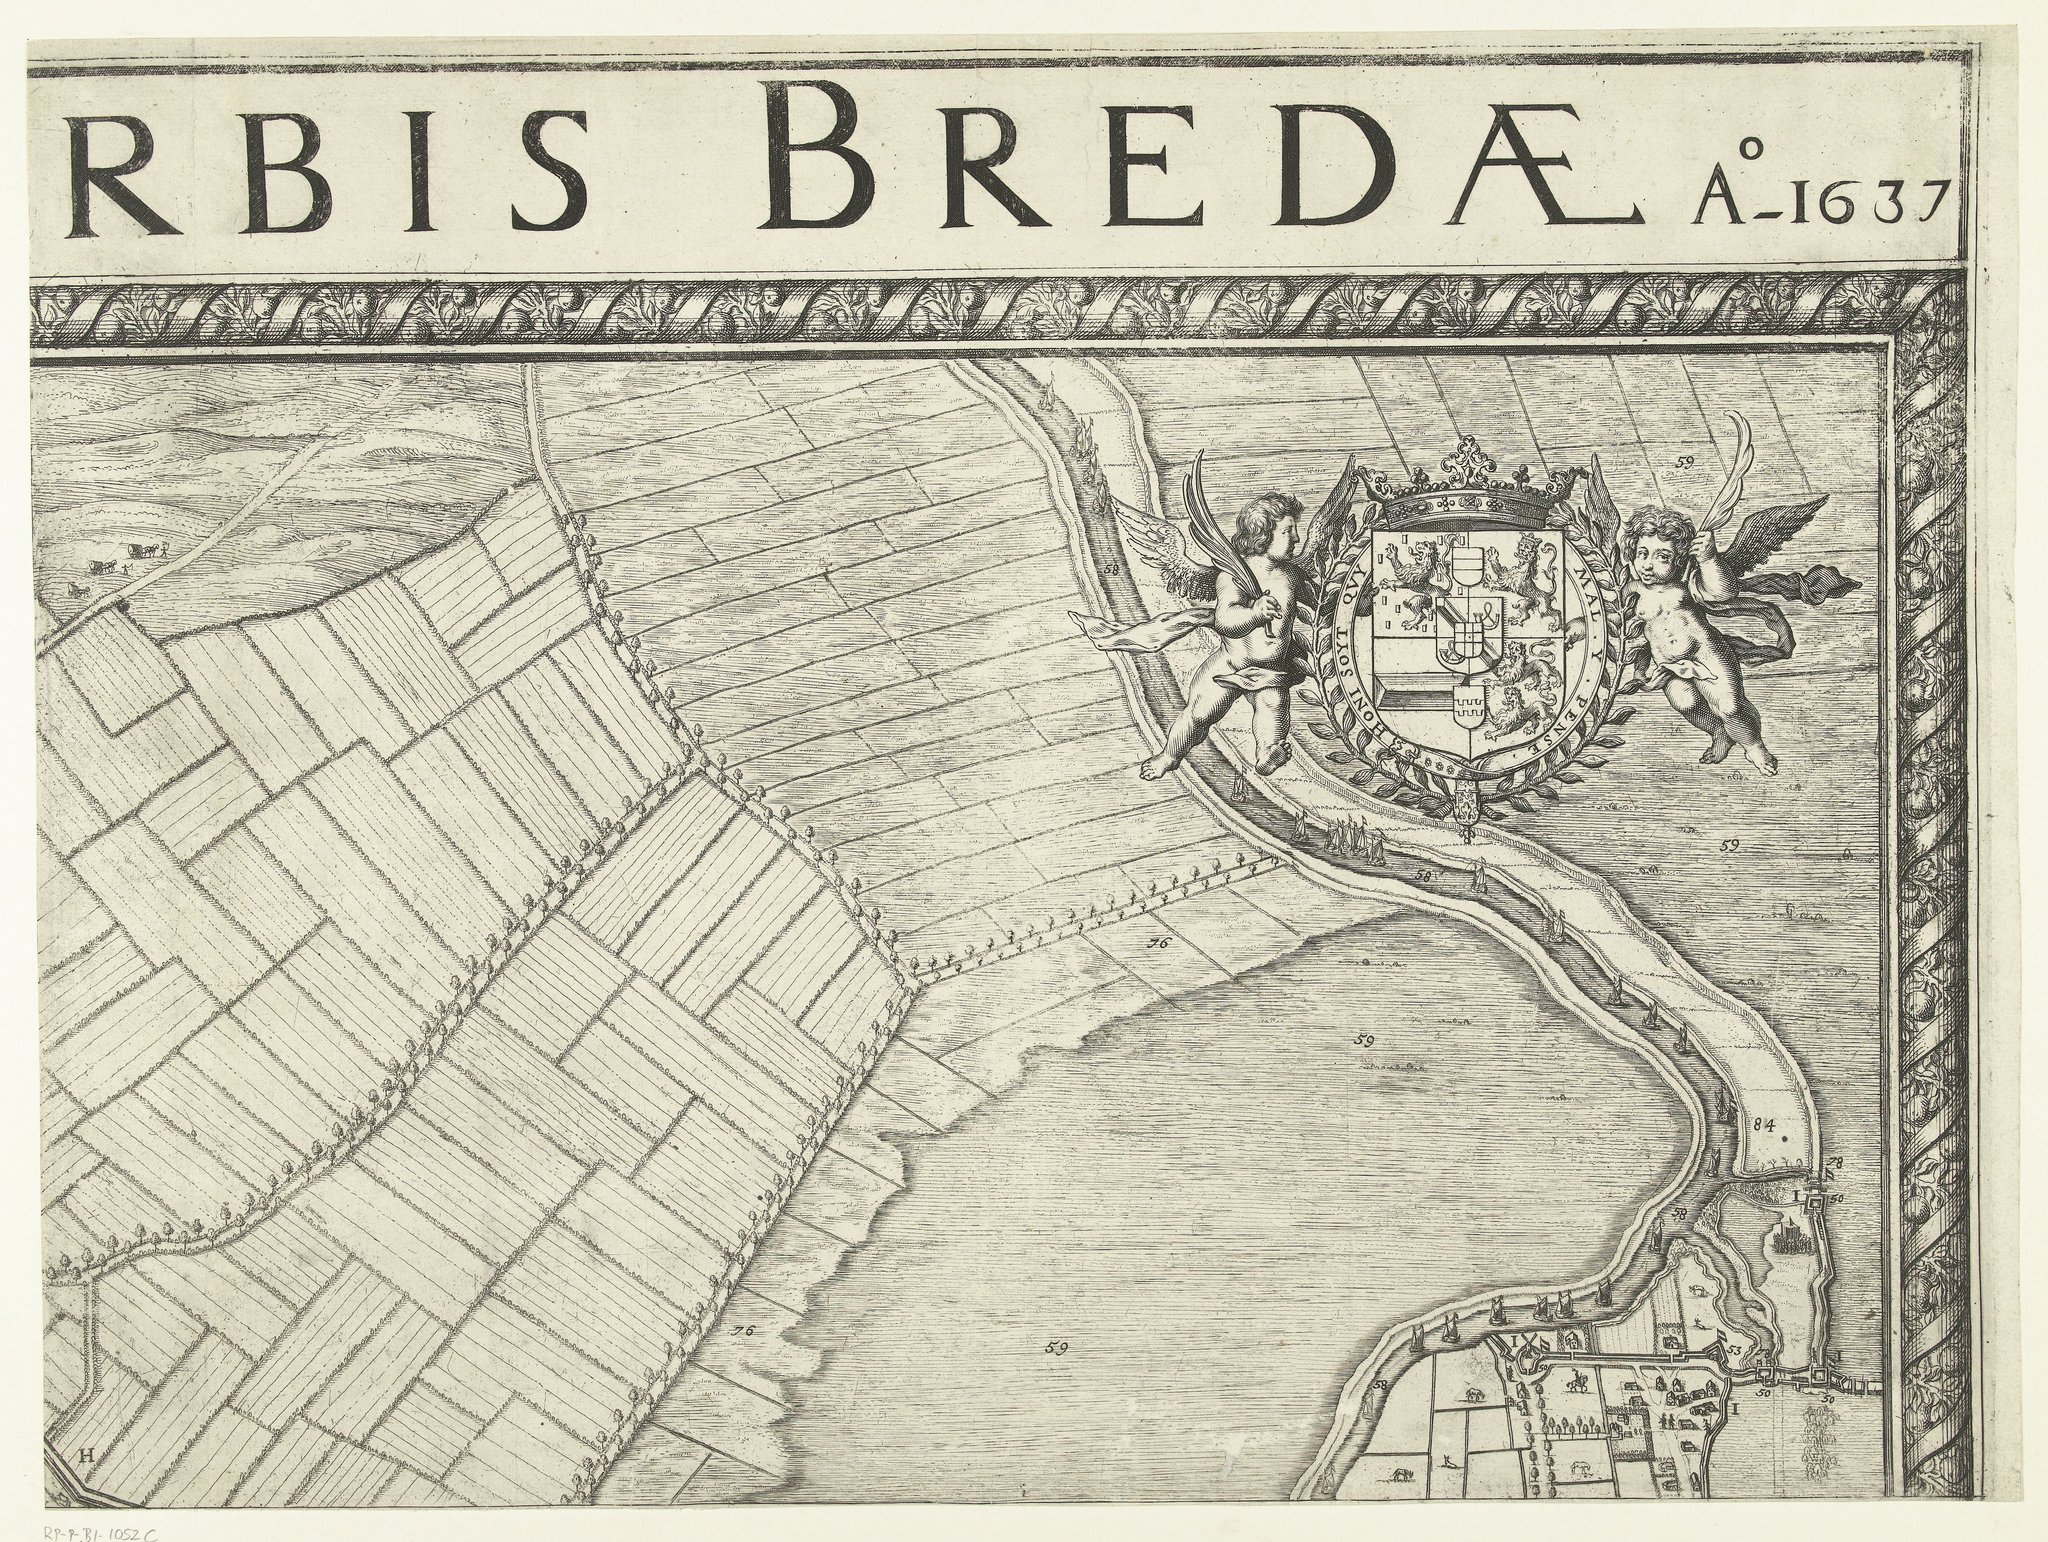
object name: map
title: Expugnatio Fortissimae Urbis Bredae Ao.-1637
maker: balthasar florisz. van berckenrode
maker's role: draughtsman, print maker, publisher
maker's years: 1591-1645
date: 1637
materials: paper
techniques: etching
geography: northern netherlands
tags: delft, the hague, frederick henry (prince of orange), maps of separate countries or regions, siege, position war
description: De belegering en verovering van Breda door het Staatse leger onder Frederik Hendrik, 23 juli - 10 oktober 1637. Onderdeel van een ongemonteerde ensemble bestaande uit 9 bladen (en 2 hier ontbrekende tekstbladen). Blad rechtsboven met het wapen van Frederik Hendrik en een deel van de kaart.